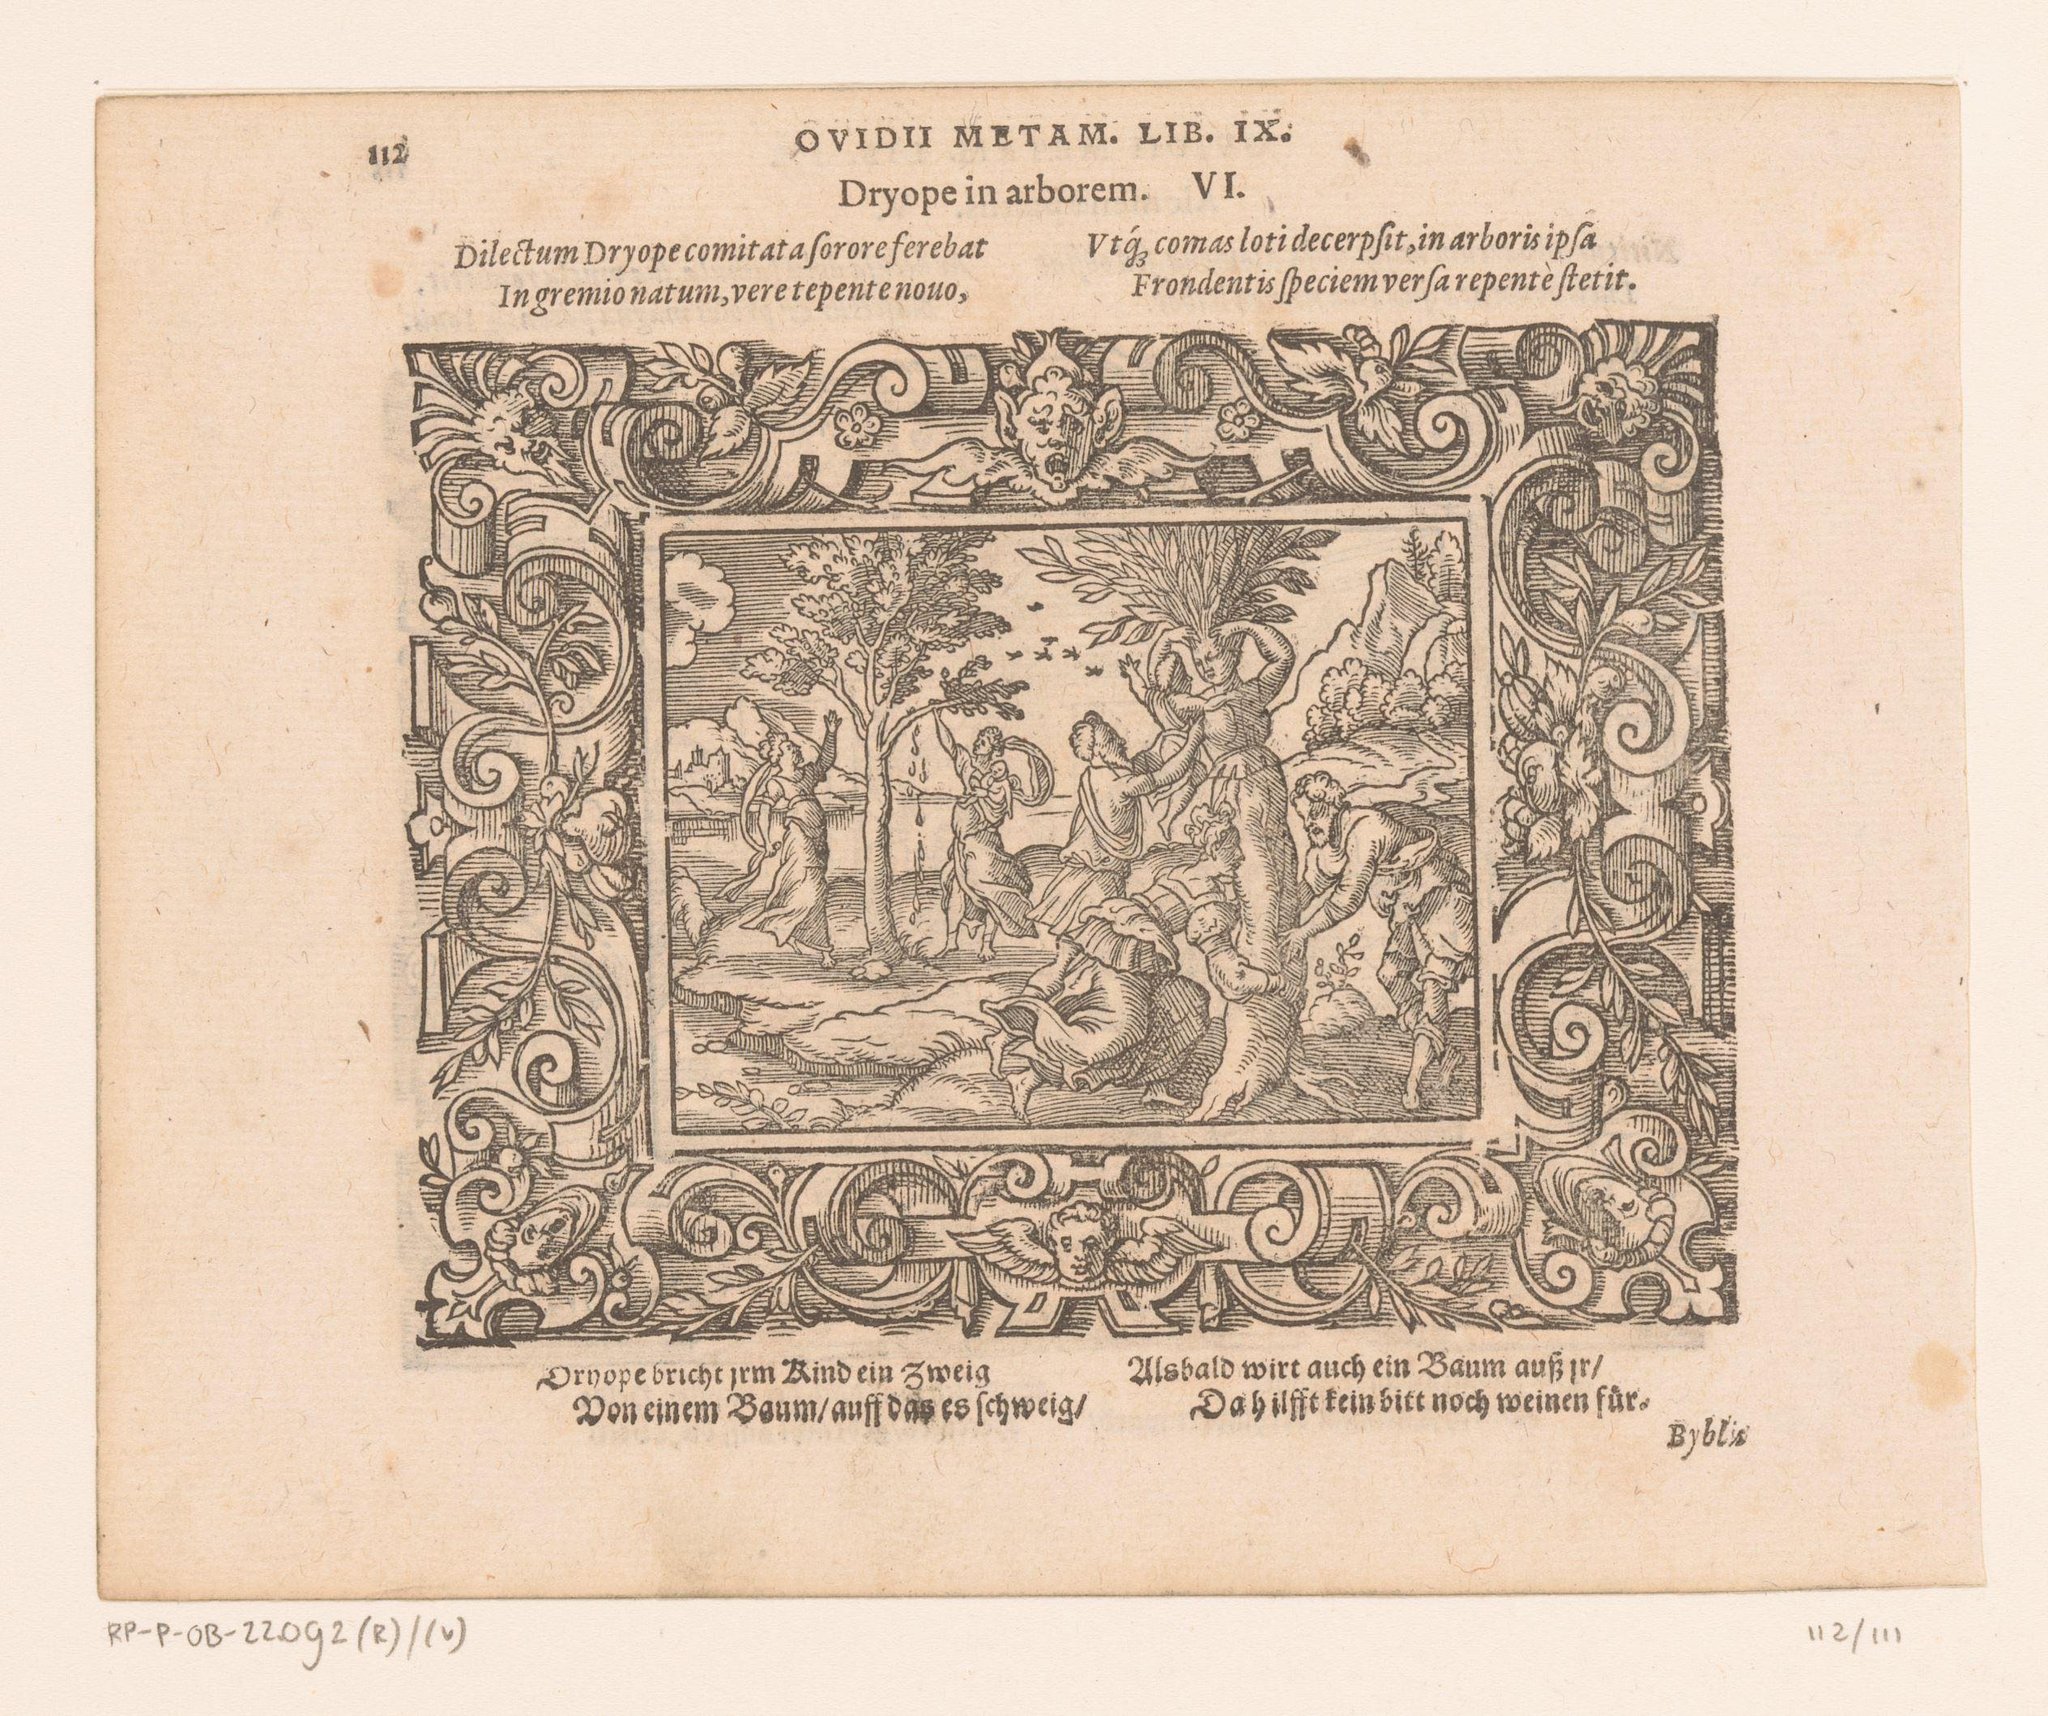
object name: print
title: Dryope in arborem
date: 1569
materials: paper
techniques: letterpress printing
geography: frankfurt am main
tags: dryope changed into a lotus-plant: dryope is changed into a lotus-plant, when to please her little boy she picks a flower from a lotus-plant (i.e. lotis metamorphosed) which then starts to bleed (ovid, metamorphoses ix 331), scrollwork, strapwork ~ ornament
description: Illustratie bij de Metamorfosen van Ovidius, afkomstig uit de publicatie: Posthius, Johannes. Tetrasticha in Ovidii metam. Frankfurt am Main: Georg Rab en Sigmund Feyerabend en erven Weigand Han, 1569. De voorstellingen en ornamentranden van deze boekillustraties zijn van twee aparte blokken gedrukt. Beide werden afzonderlijk van elkaar ook gebruikt voor andere publicaties, en de ornamentranden werden eveneens binnen deze publicatie meerdere keren gebruikt.